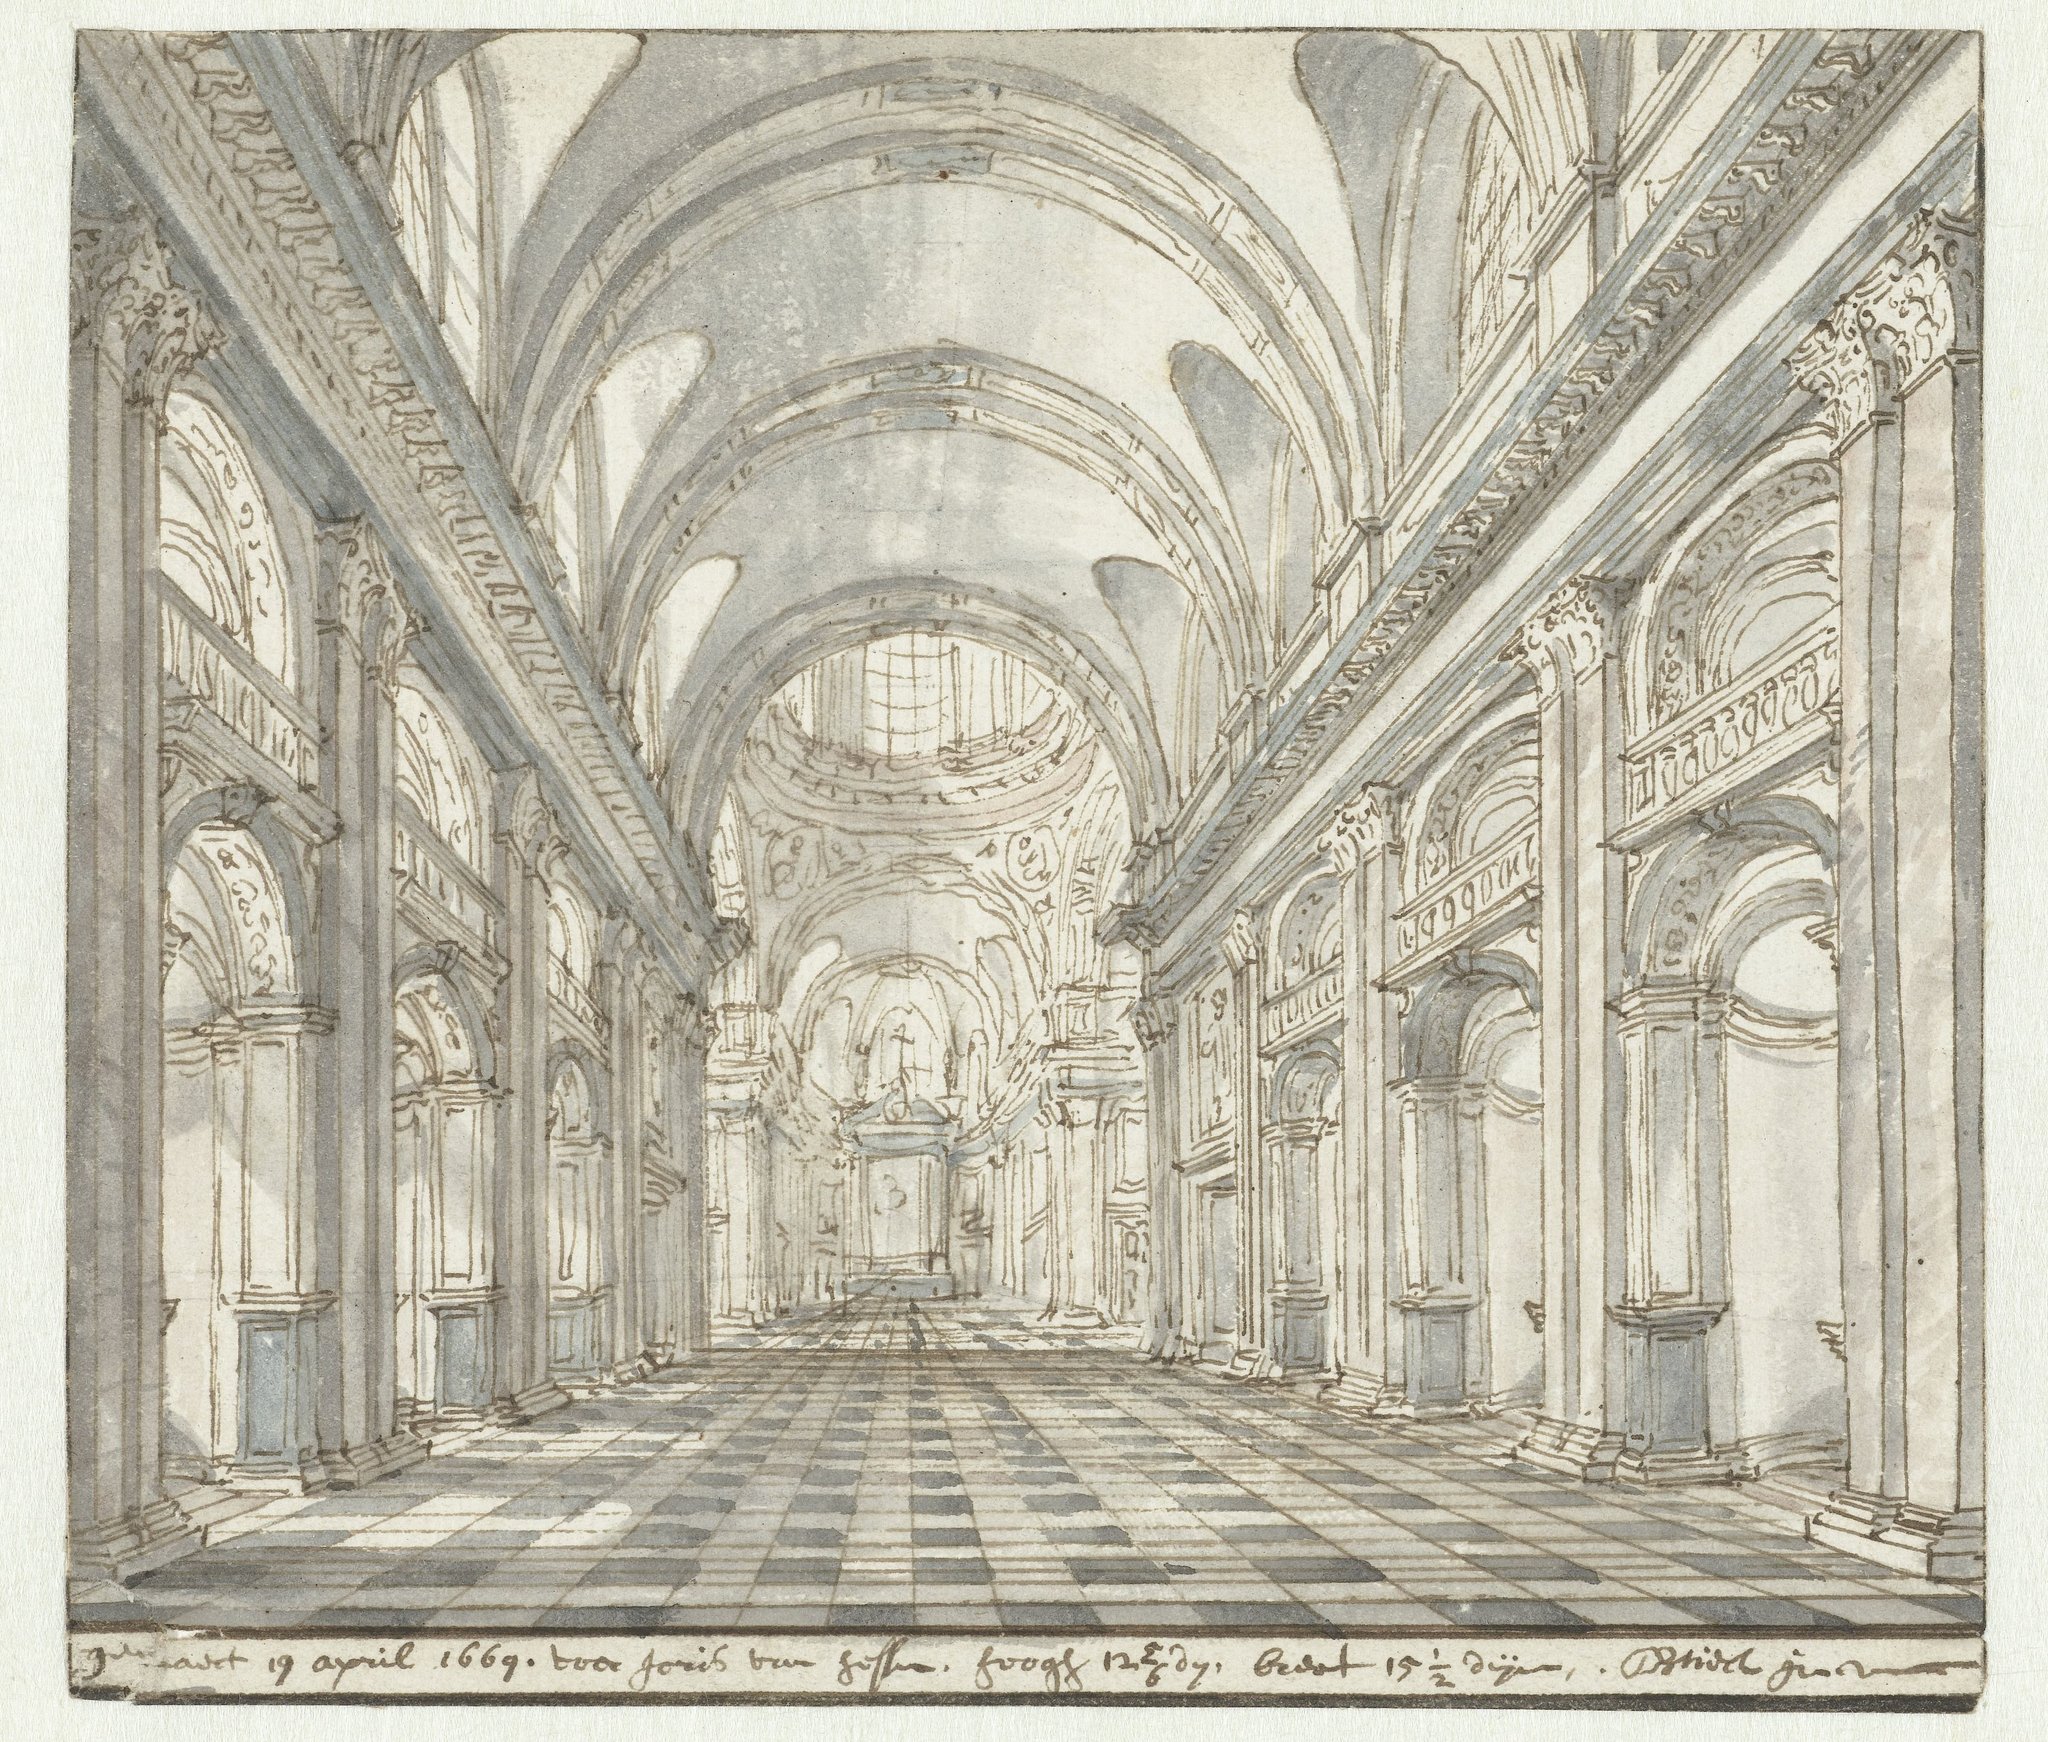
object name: drawing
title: Interieur van een barokke kerk (Sint Pieter, Rome?)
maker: daniël de blieck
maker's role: draughtsman, painter, print maker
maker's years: 1608-1673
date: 1669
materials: chalk, graphite, ink, paper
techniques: brush, pen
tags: interior of church